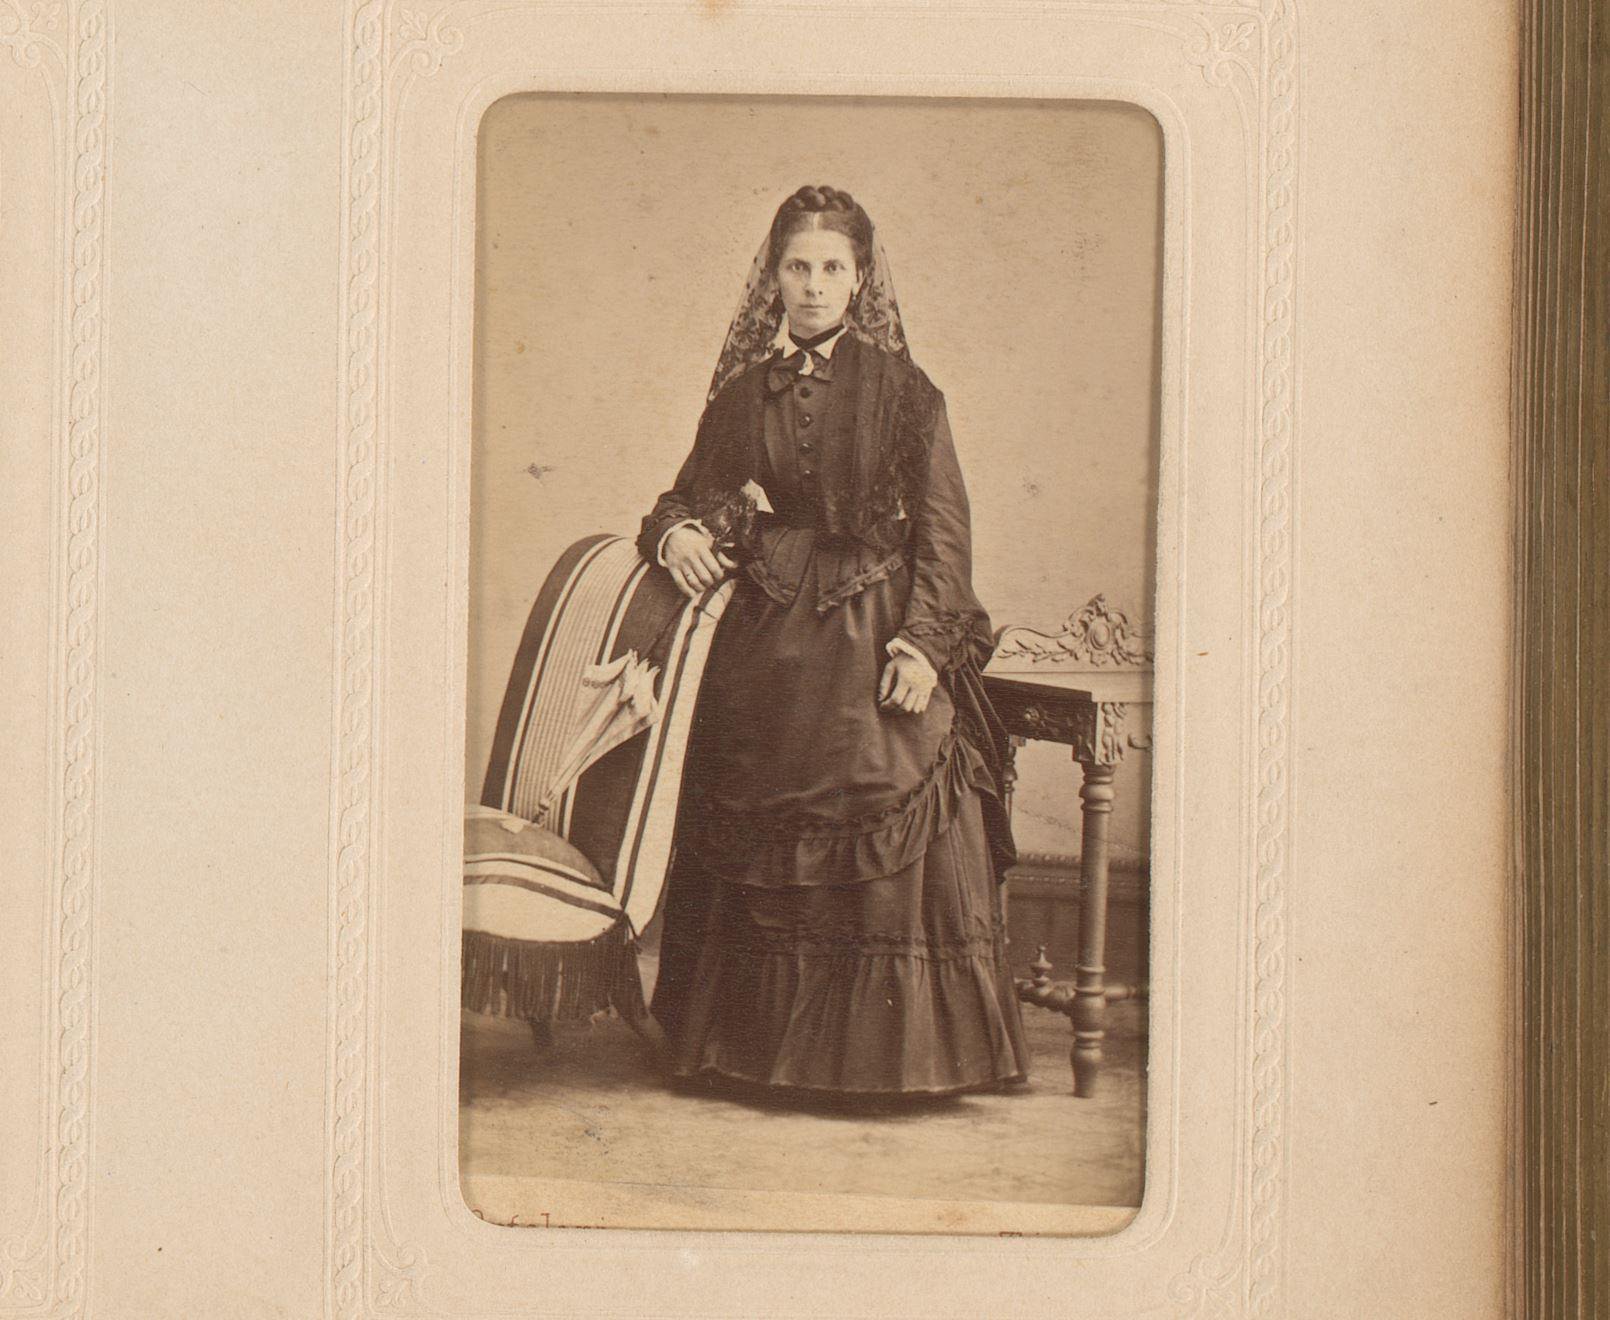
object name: photograph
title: Portret van een vrouw met paraplu in de hand, staand bij een stoel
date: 1860-1900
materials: cardboard, photographic support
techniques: albumen print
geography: trieste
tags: historical persons - bb - woman, umbrella, standing figure - aa - female human figure, chair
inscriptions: inscription: ‘Fotografia/ Ortolani/ Trieste/ Via delle Torri No 3 dietro St. Antonio Nuovo.’